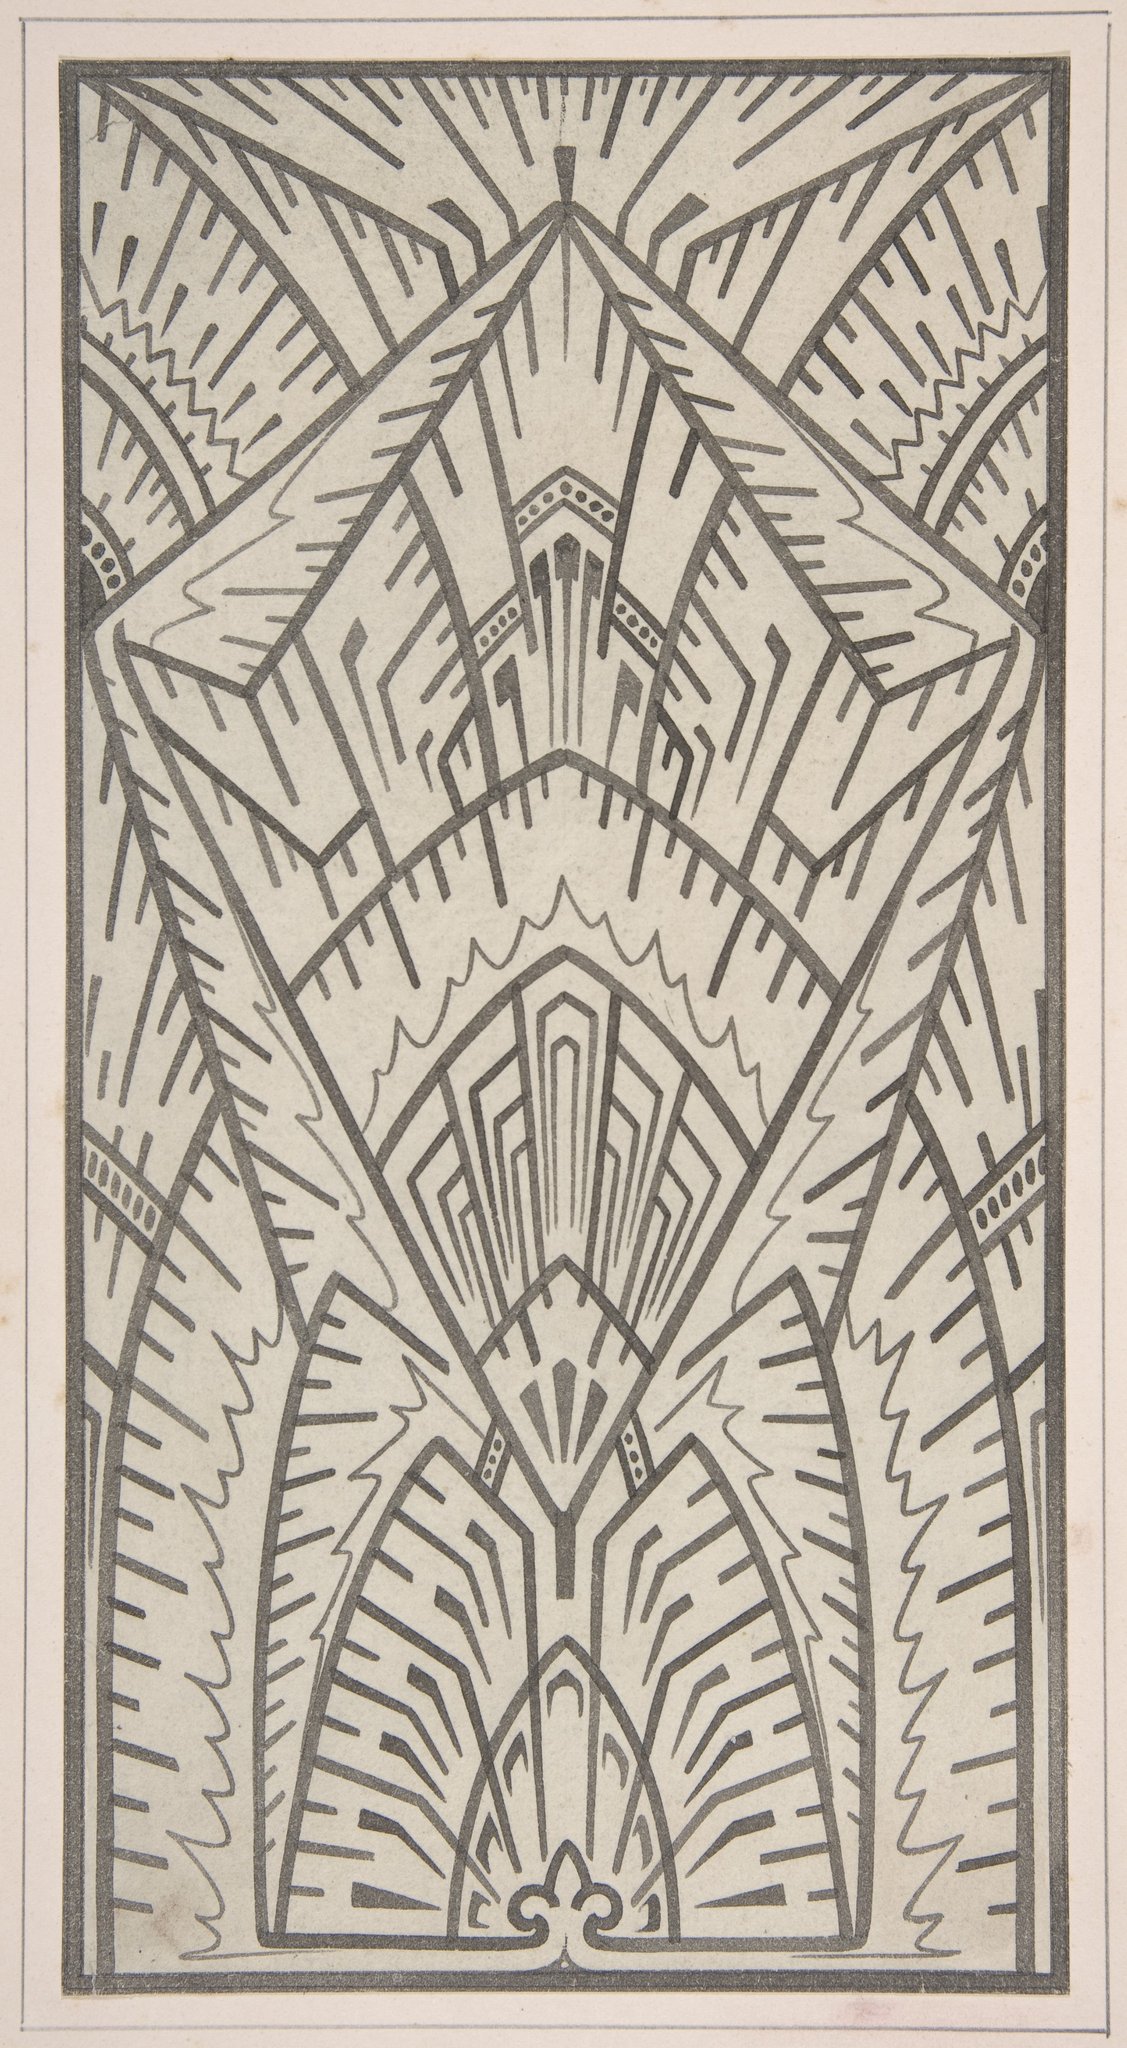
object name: drawing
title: Design drawing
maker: christopher dresser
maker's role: designer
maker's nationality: british, scottish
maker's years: 1834-1904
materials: gouache, graphite, ink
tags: abstraction